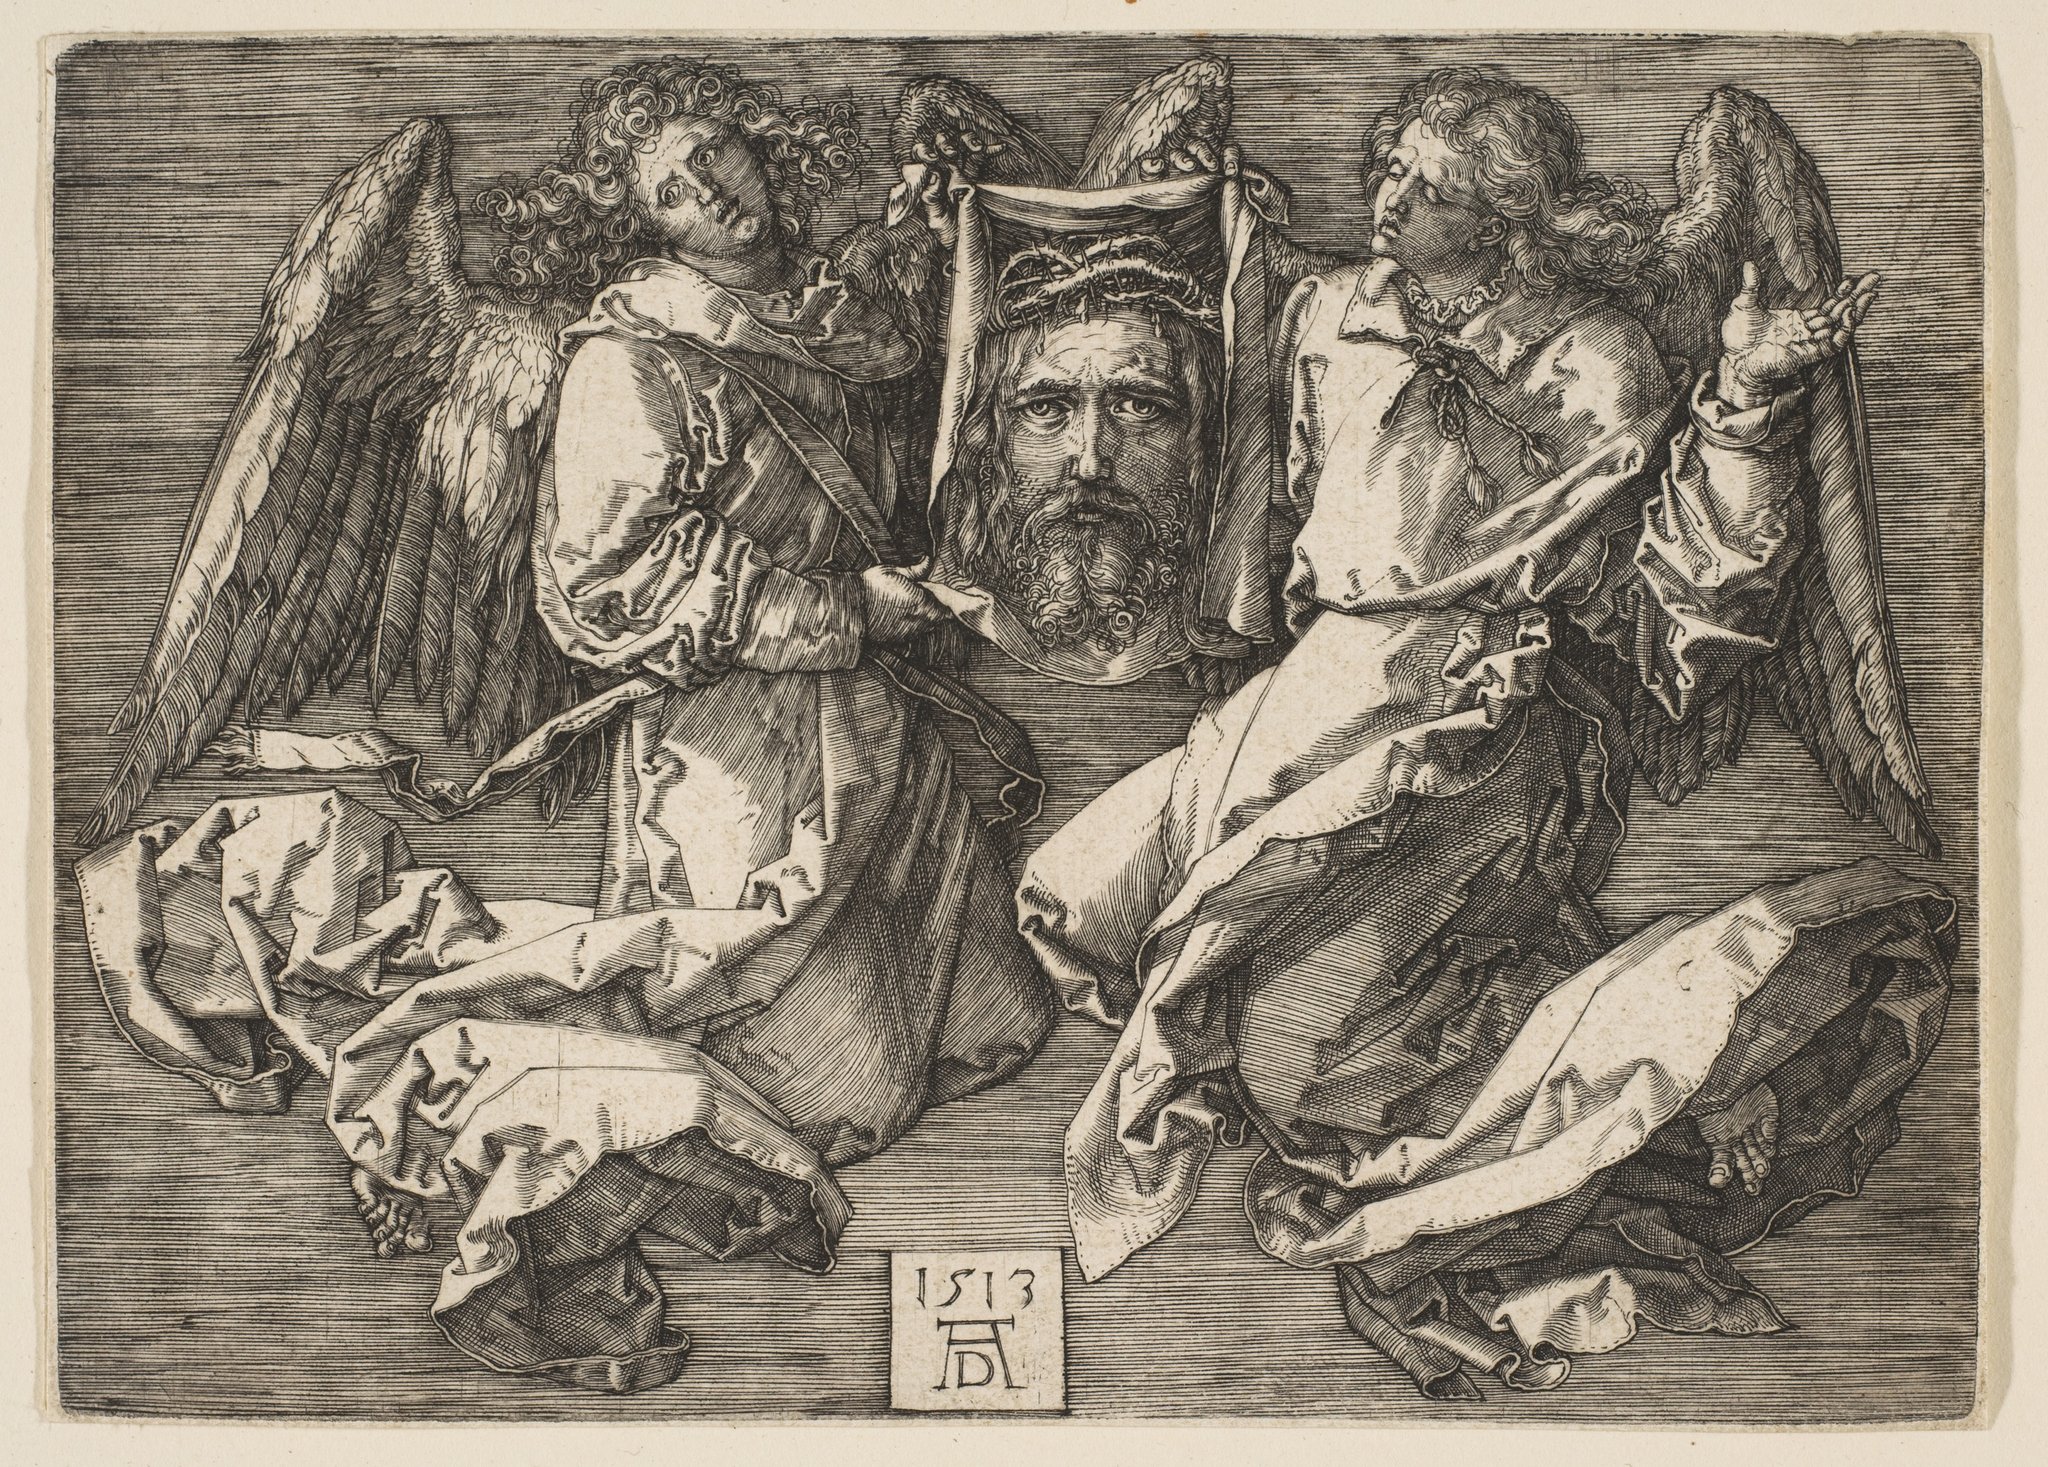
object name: print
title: Sudarium displayed by two Angels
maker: albrecht dürer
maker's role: artist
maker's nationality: german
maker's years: 1471-1528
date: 1513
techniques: engraving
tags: faces,angels